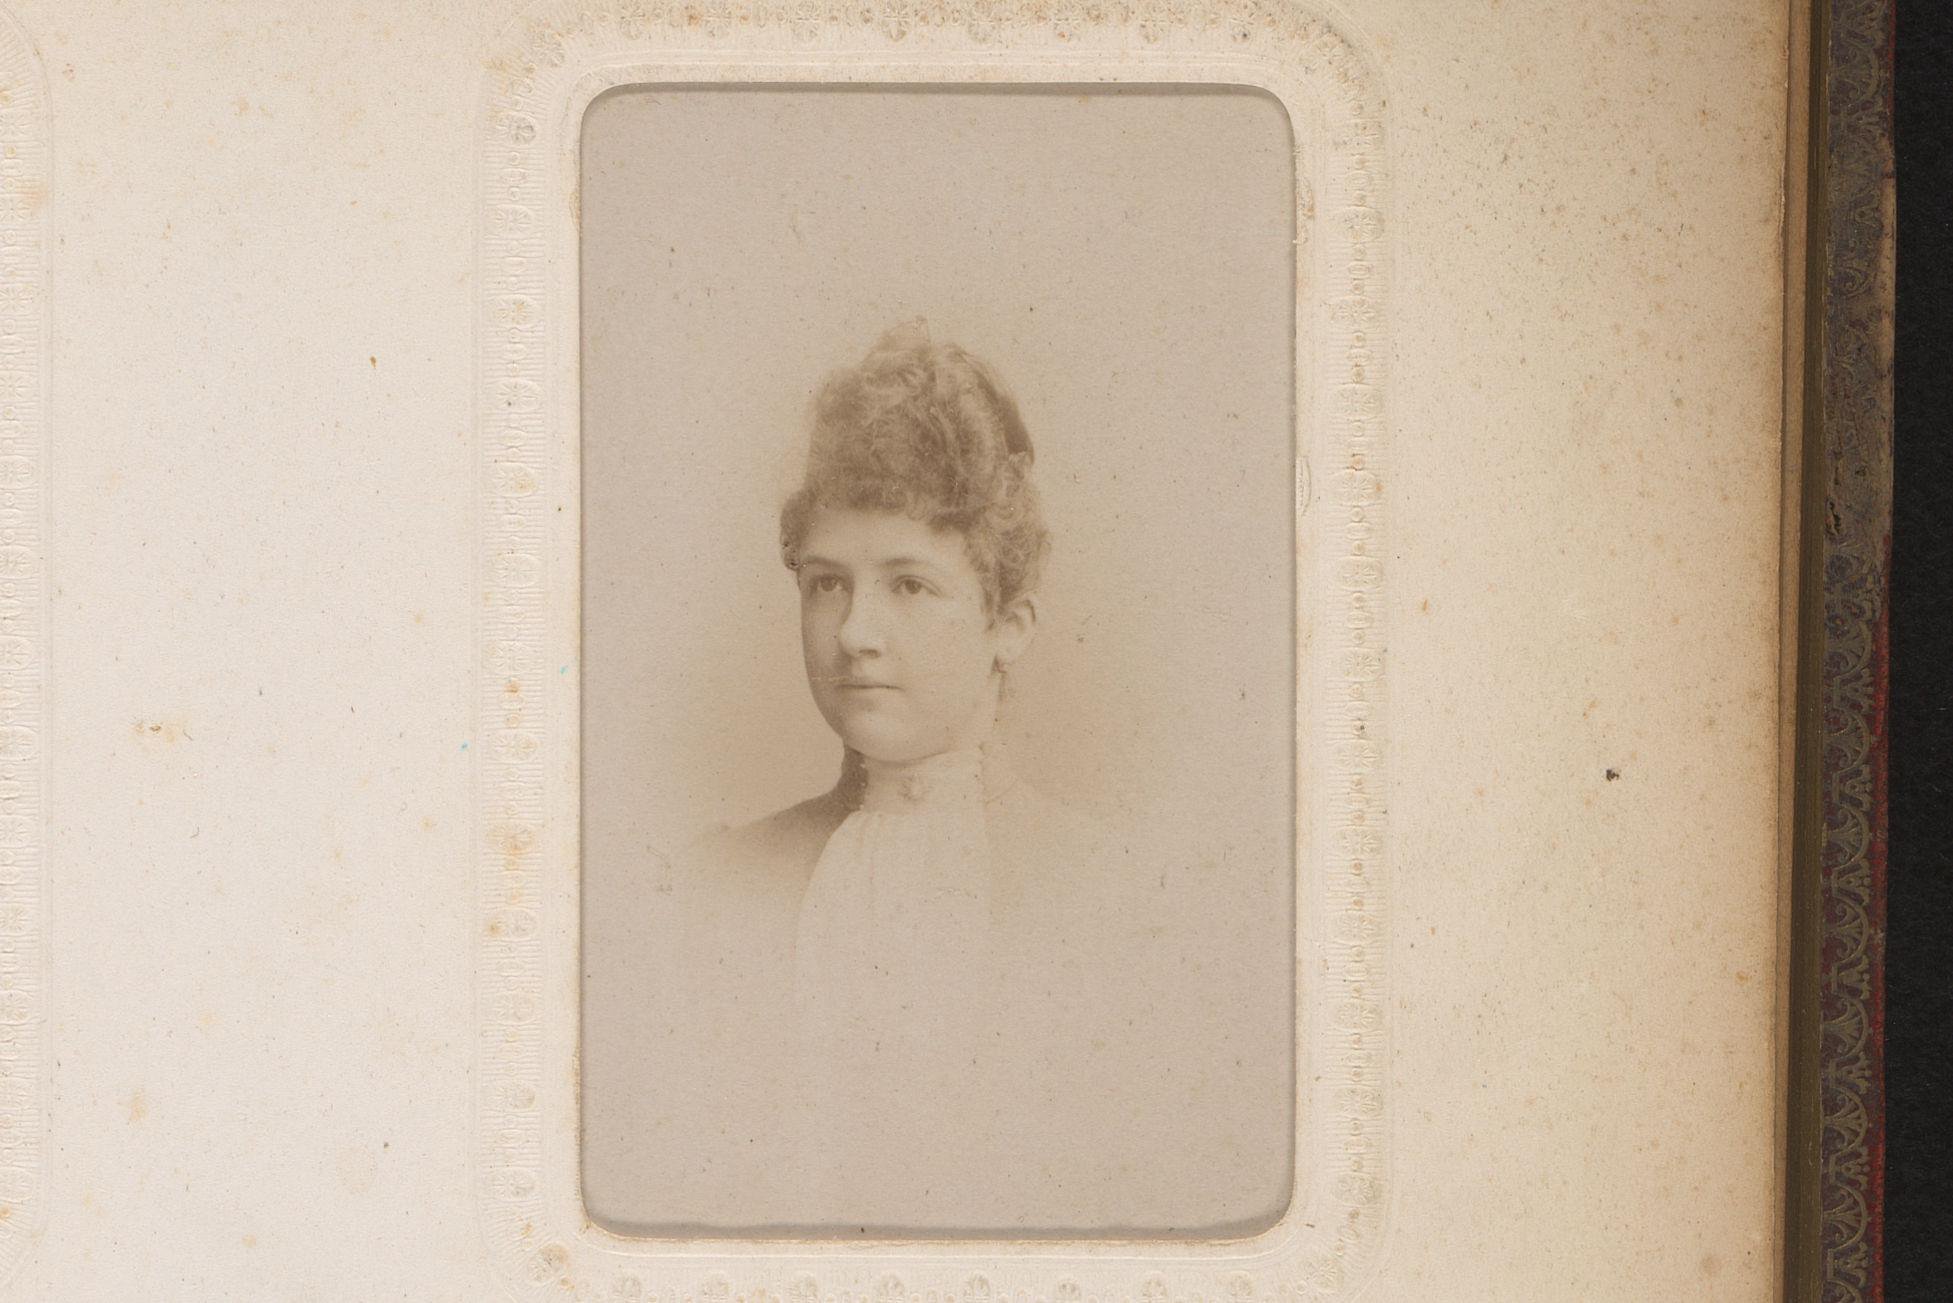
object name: photograph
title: Portret van een jonge vrouw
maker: Anonymous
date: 1860-1900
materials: cardboard, photographic support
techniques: albumen print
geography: netherlands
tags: adolescent, young woman, maiden, historical persons - bb - woman